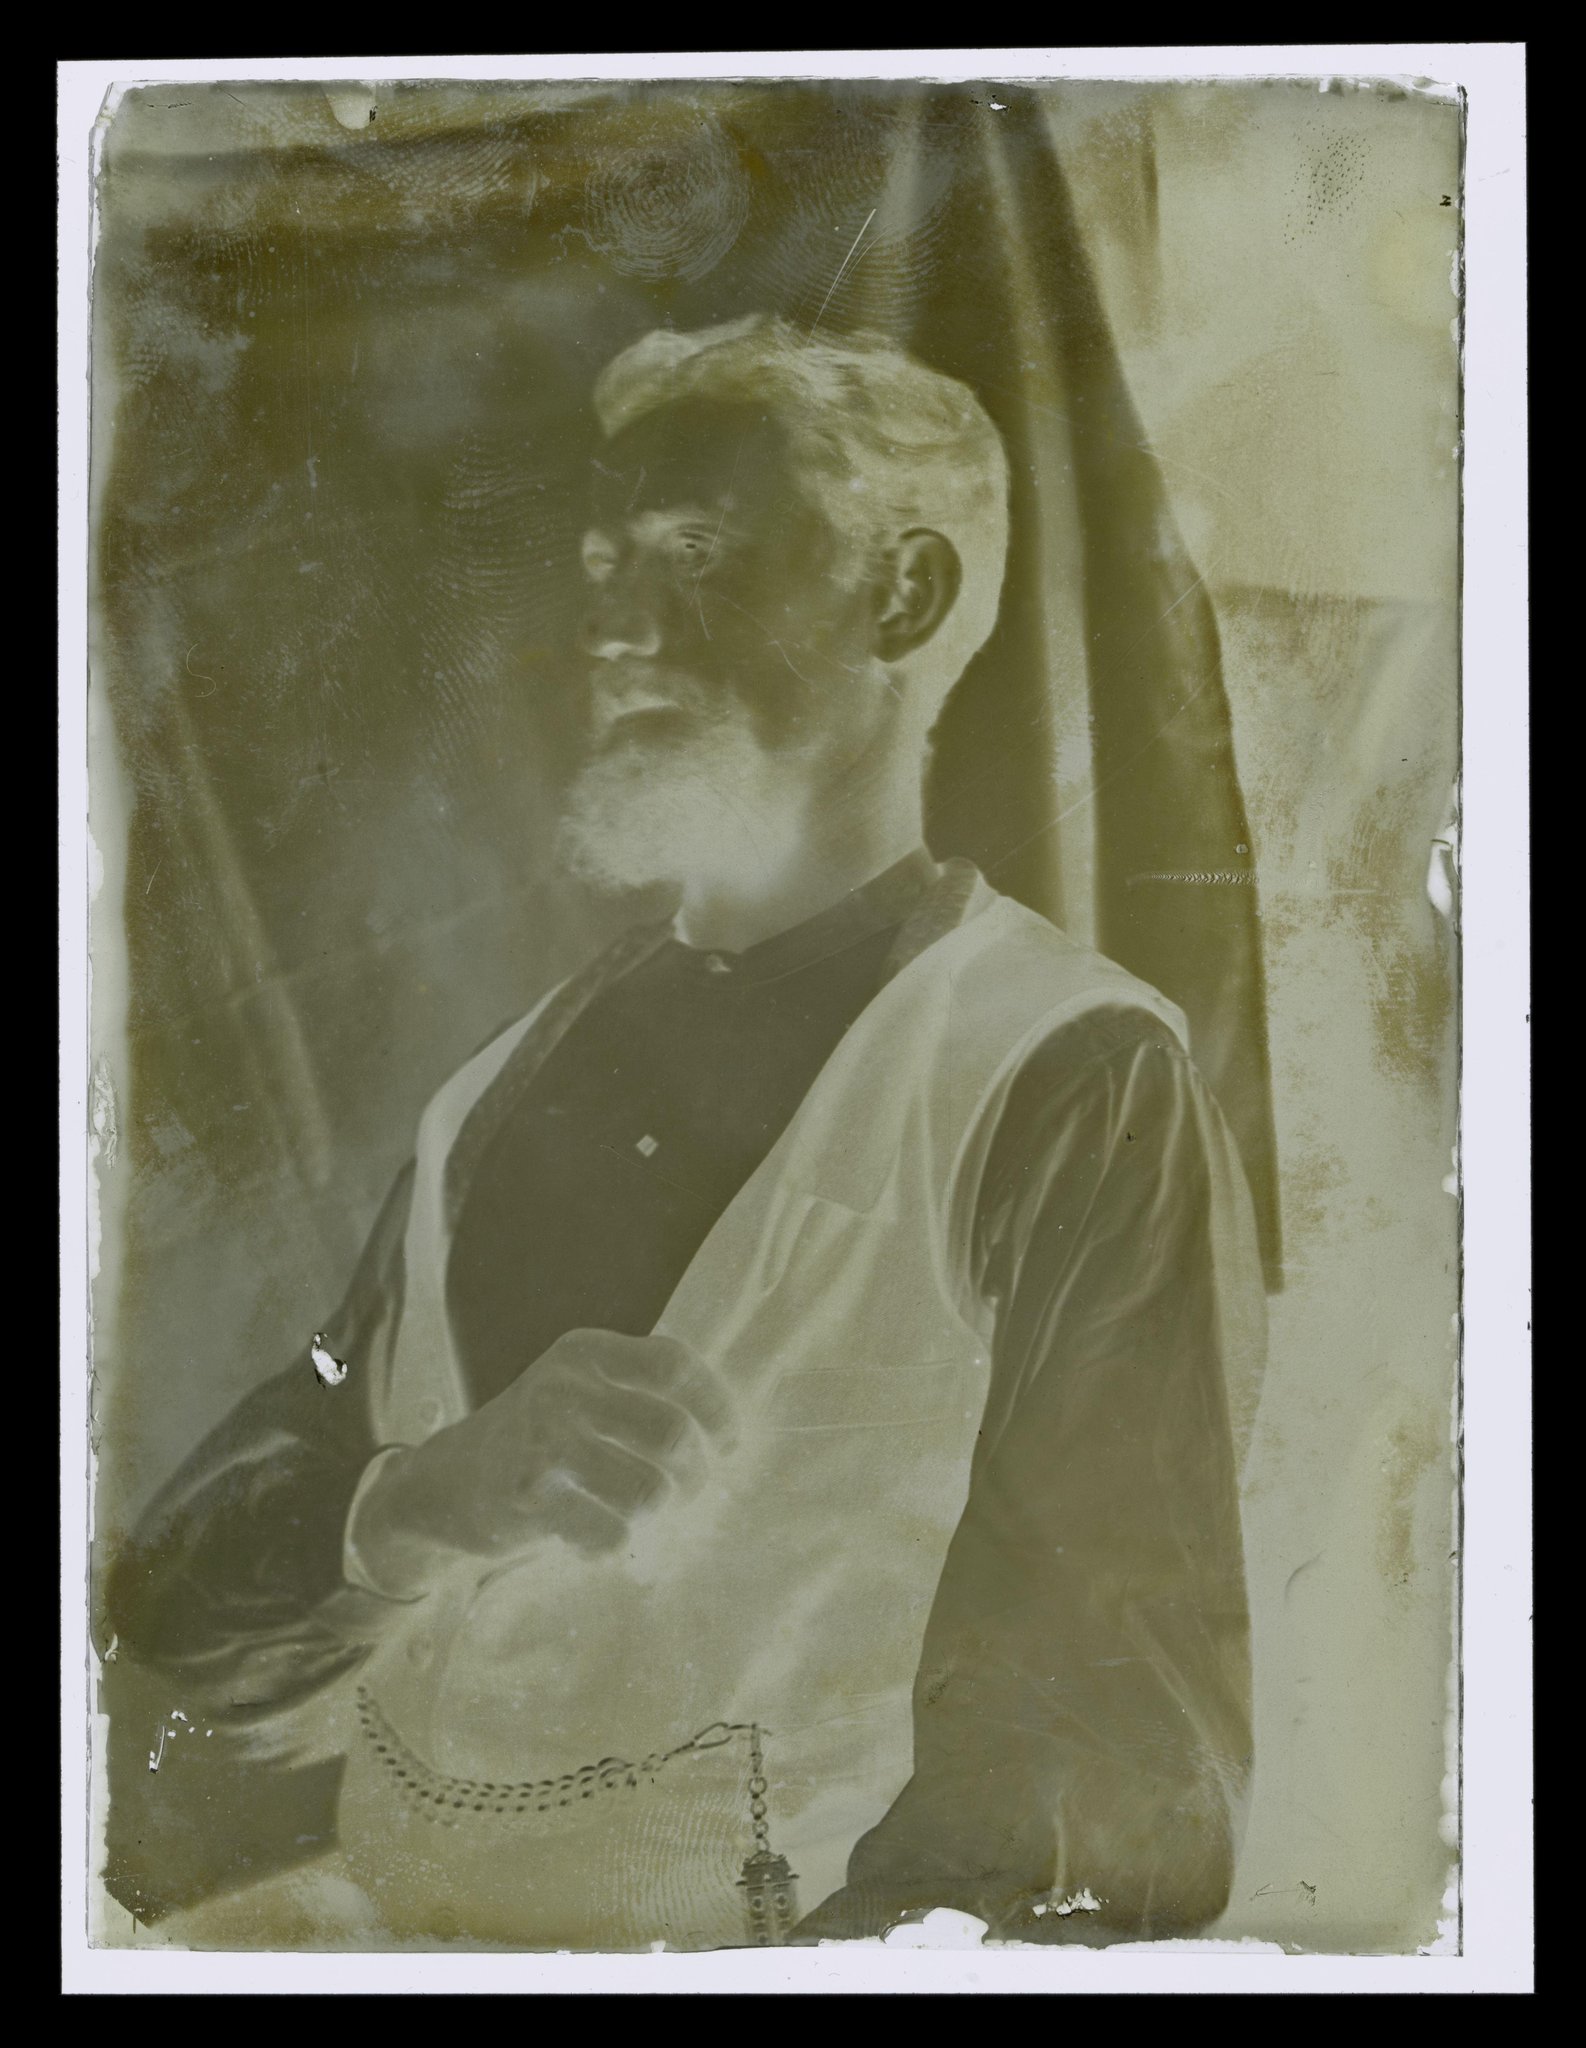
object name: glasnegatief, glasplaatnegatief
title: Portret van een man, mogelijk een zelfportret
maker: laurens lodewijk kleijn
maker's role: draughtsman, painter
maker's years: 1826-1909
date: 1865-1900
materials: glass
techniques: collodion process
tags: painter, draughtsman, laurens lodewijk kleijn, portrait, self-portrait of artist, historical persons (portraits and scenes from the life)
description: Onderdeel van een groep glasnegatieven uit de nalatenschap van de schilder Laurens Lodewijk Kleijn, met stillevens, portretten, zelfportretten en kunstreproducties.